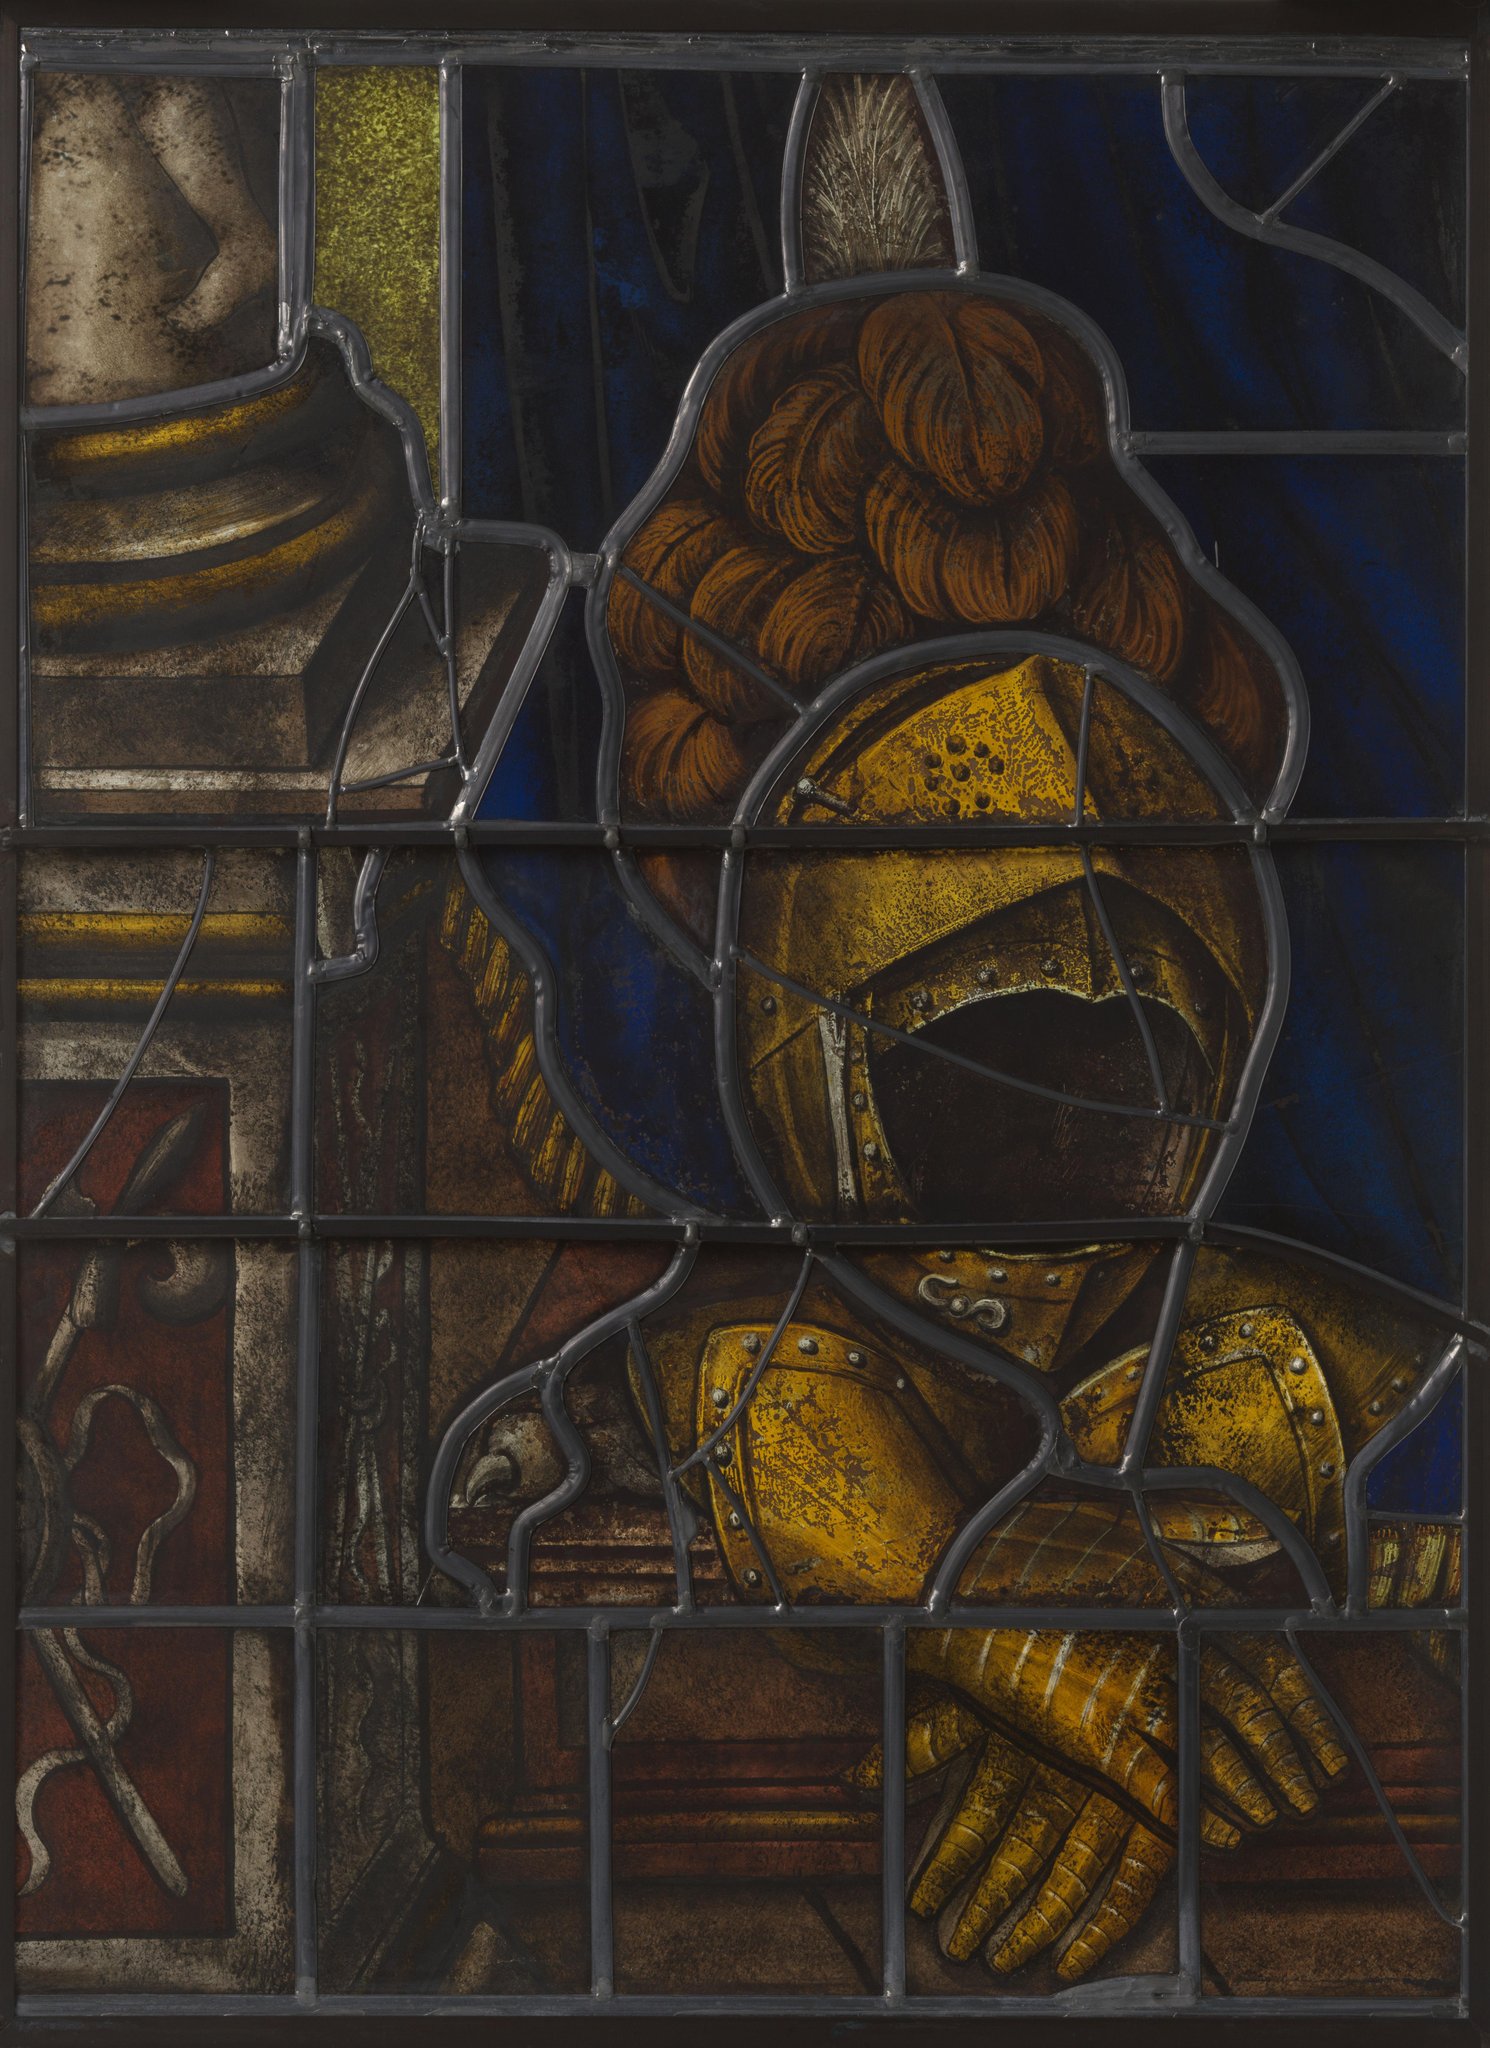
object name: light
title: Eerste paneel van ruit met Prins Maurits in biddende houding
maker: Anonymous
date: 1618-1620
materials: glass, lead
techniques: leading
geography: netherlands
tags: the hague, maurice (prince of orange)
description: Groot raam afkomstig uit het klooster van St Agatha bij Cuyk. Prins Maurits in verguld harnas, met hermelijnen mantel en geplooide kraag, blootshoofds, in biddende houding, geknield op een bidstoel voor een lessenaar waarop een boek. De lessenaar staat op een tafel met een donkerblauw kleed met gouden franje gedekt. Helm en handschoenen liggen op de grond voor de tafel. De prins bevindt zich in een koepel door vier vrijstaande Korintische zuilen gedragen; boven zijn hoofd een baldakijn waaruit een lauwerkrans afhangt. De koepel wordt bekroond door het wapen van Maurits en het devies van de Orde van de Kousenband: 'Honi soit qui mal y pense' (Schande over hem die er kwaad van denkt). Wapen door twee lopende jongelingen gesteund. Het wapen leunt tegen het bovenstuk van de koepel. Onder dit tafereel bevinden zich brokstukken architectuur die onoordeelkundig zijn aangebracht. Rechts ligt een jonge vrouw geknield met opgeheven handen. Zij draagt een geel zijden mantel met hermelijn omzoomd. Het gezicht is in olieverf bijgemaakt in 1891.